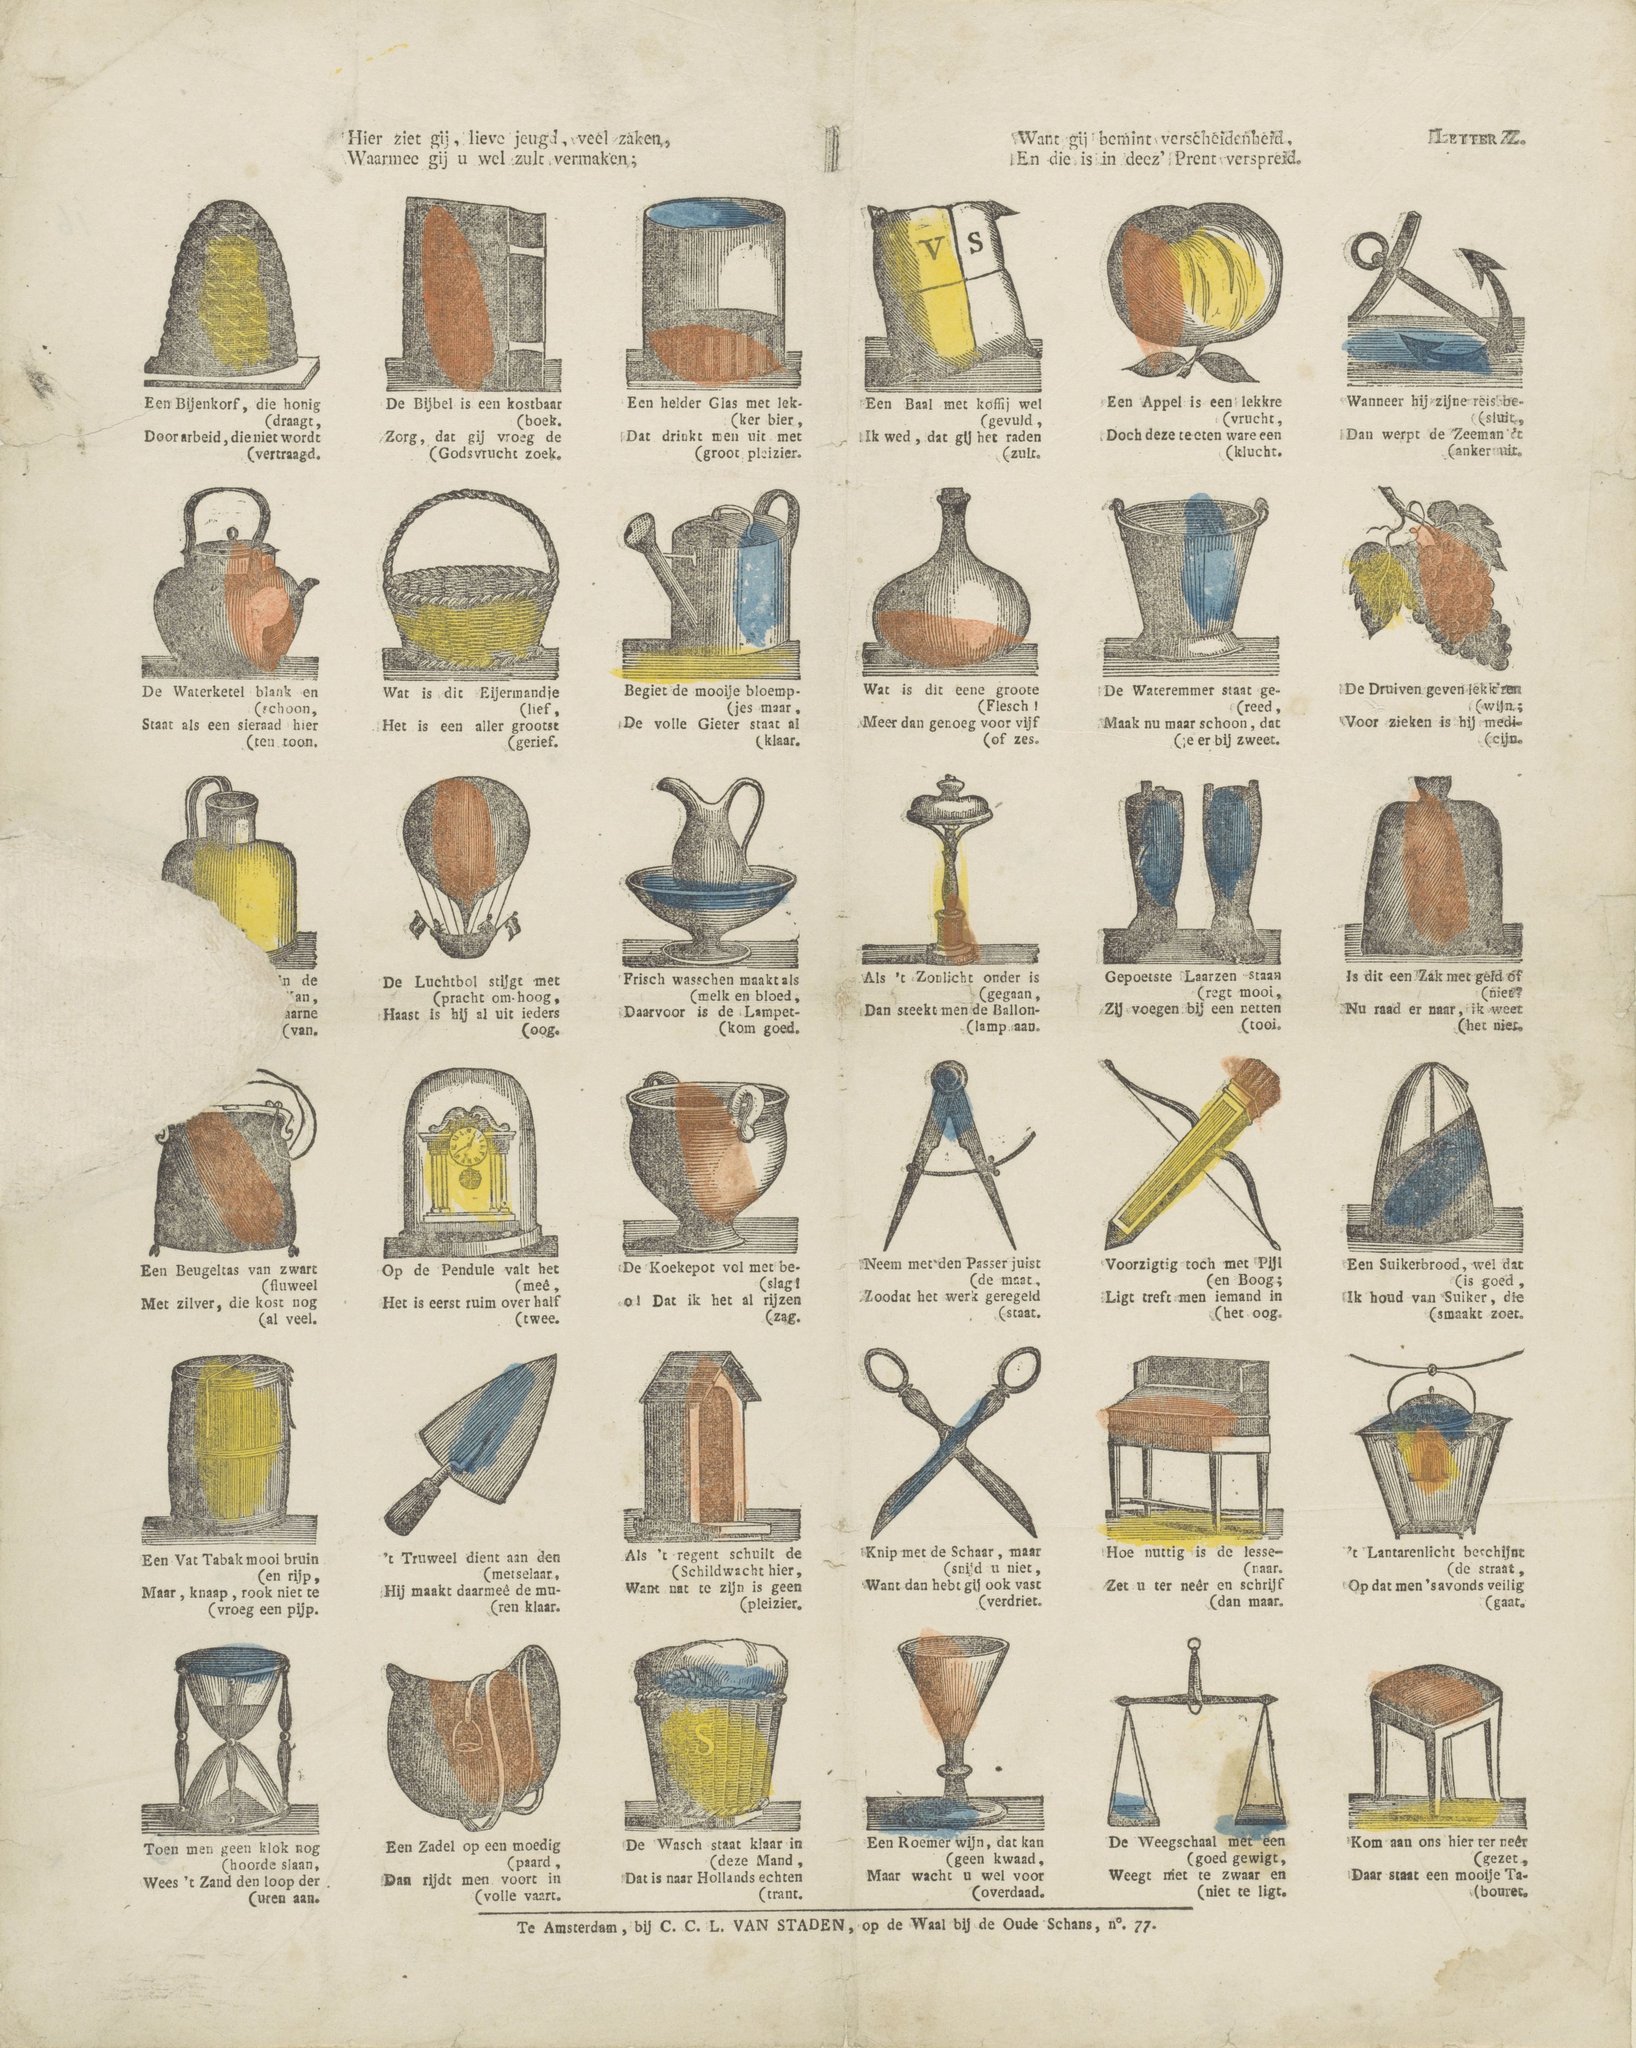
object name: popular print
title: Hier ziet gij, lieve jeugd, veel zaken, / Waarmee gij u wel zult vermaken; / Want gij bemint verscheidenheid, / En die is in deez' prent verspreid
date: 1822-1870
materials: paper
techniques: colour, letterpress printing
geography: netherlands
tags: tools, aids, implements ~ crafts and industries, (household) utensils and implements, fruits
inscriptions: collector's mark: Lugt 2760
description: Blad met 36 voorstellingen van verschillende voorwerpen, zoals een bijenkorf, een bijbel, een glas en een eiermandje. Onder elke afbeelding een vers. Rechtsboven gemerkt: Letter Z.